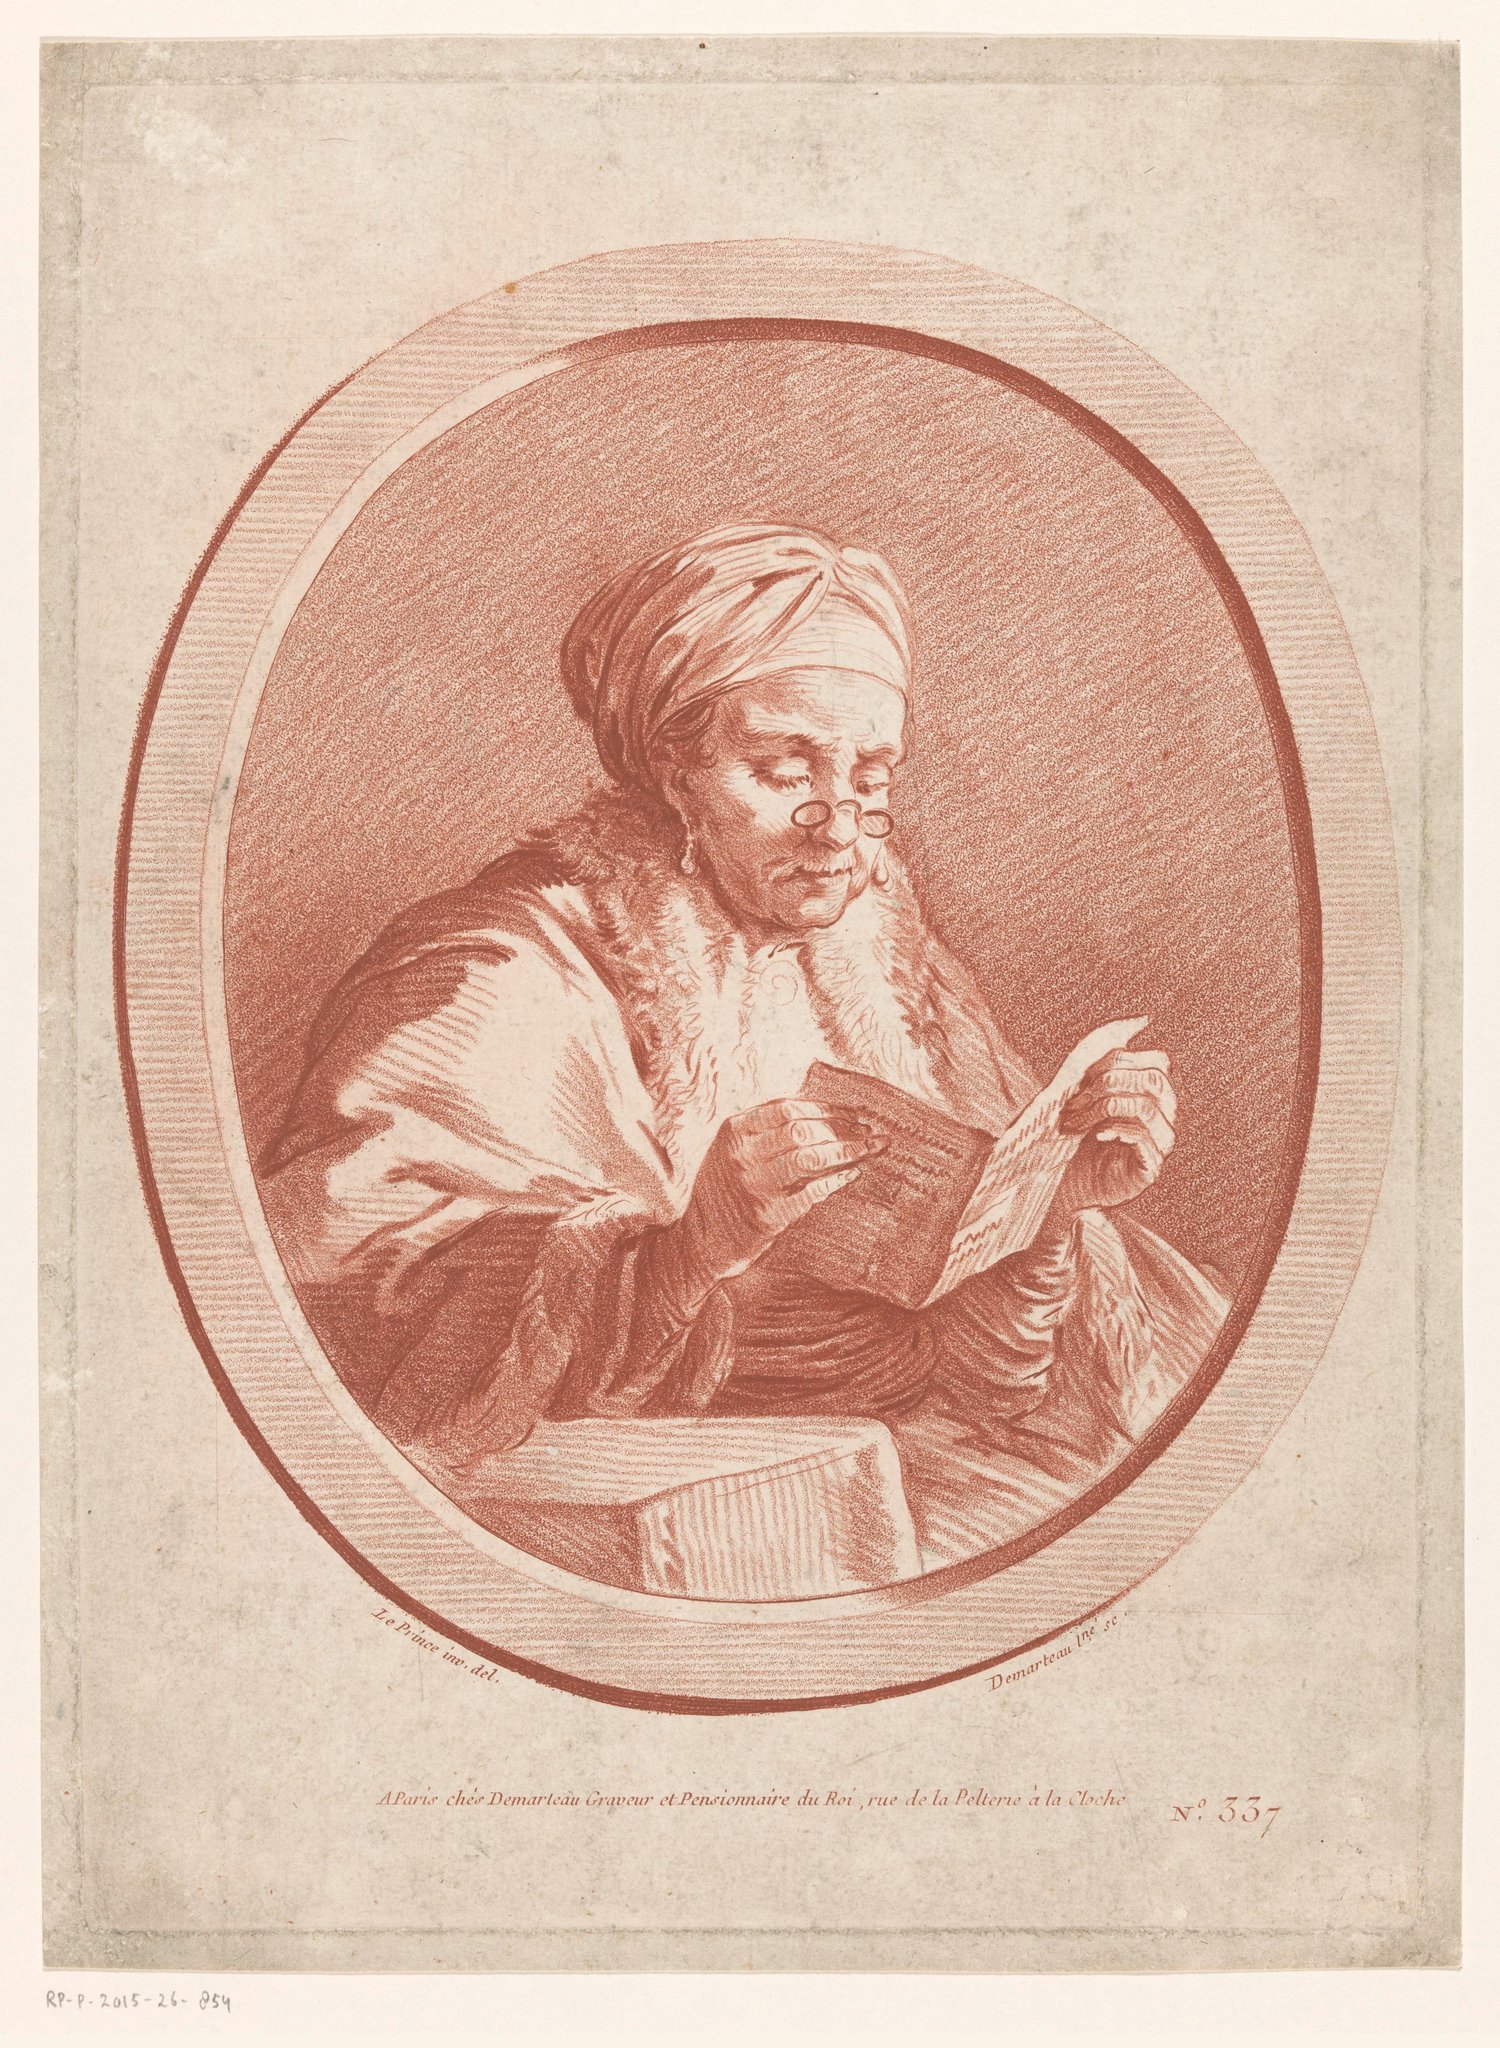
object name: print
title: Oude vrouw leest een brief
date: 1744-1776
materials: paper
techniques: printmaking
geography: paris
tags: letter, envelope, newspaper, news-sheet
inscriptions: collector's mark: Lugt 4779, collector's mark: Lugt 2228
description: Het nummer verwijst naar de oeuvre-catalogus van Demarteau, uitgegeven in 1788 door diens neef, Gilles-Antoine Demarteau.